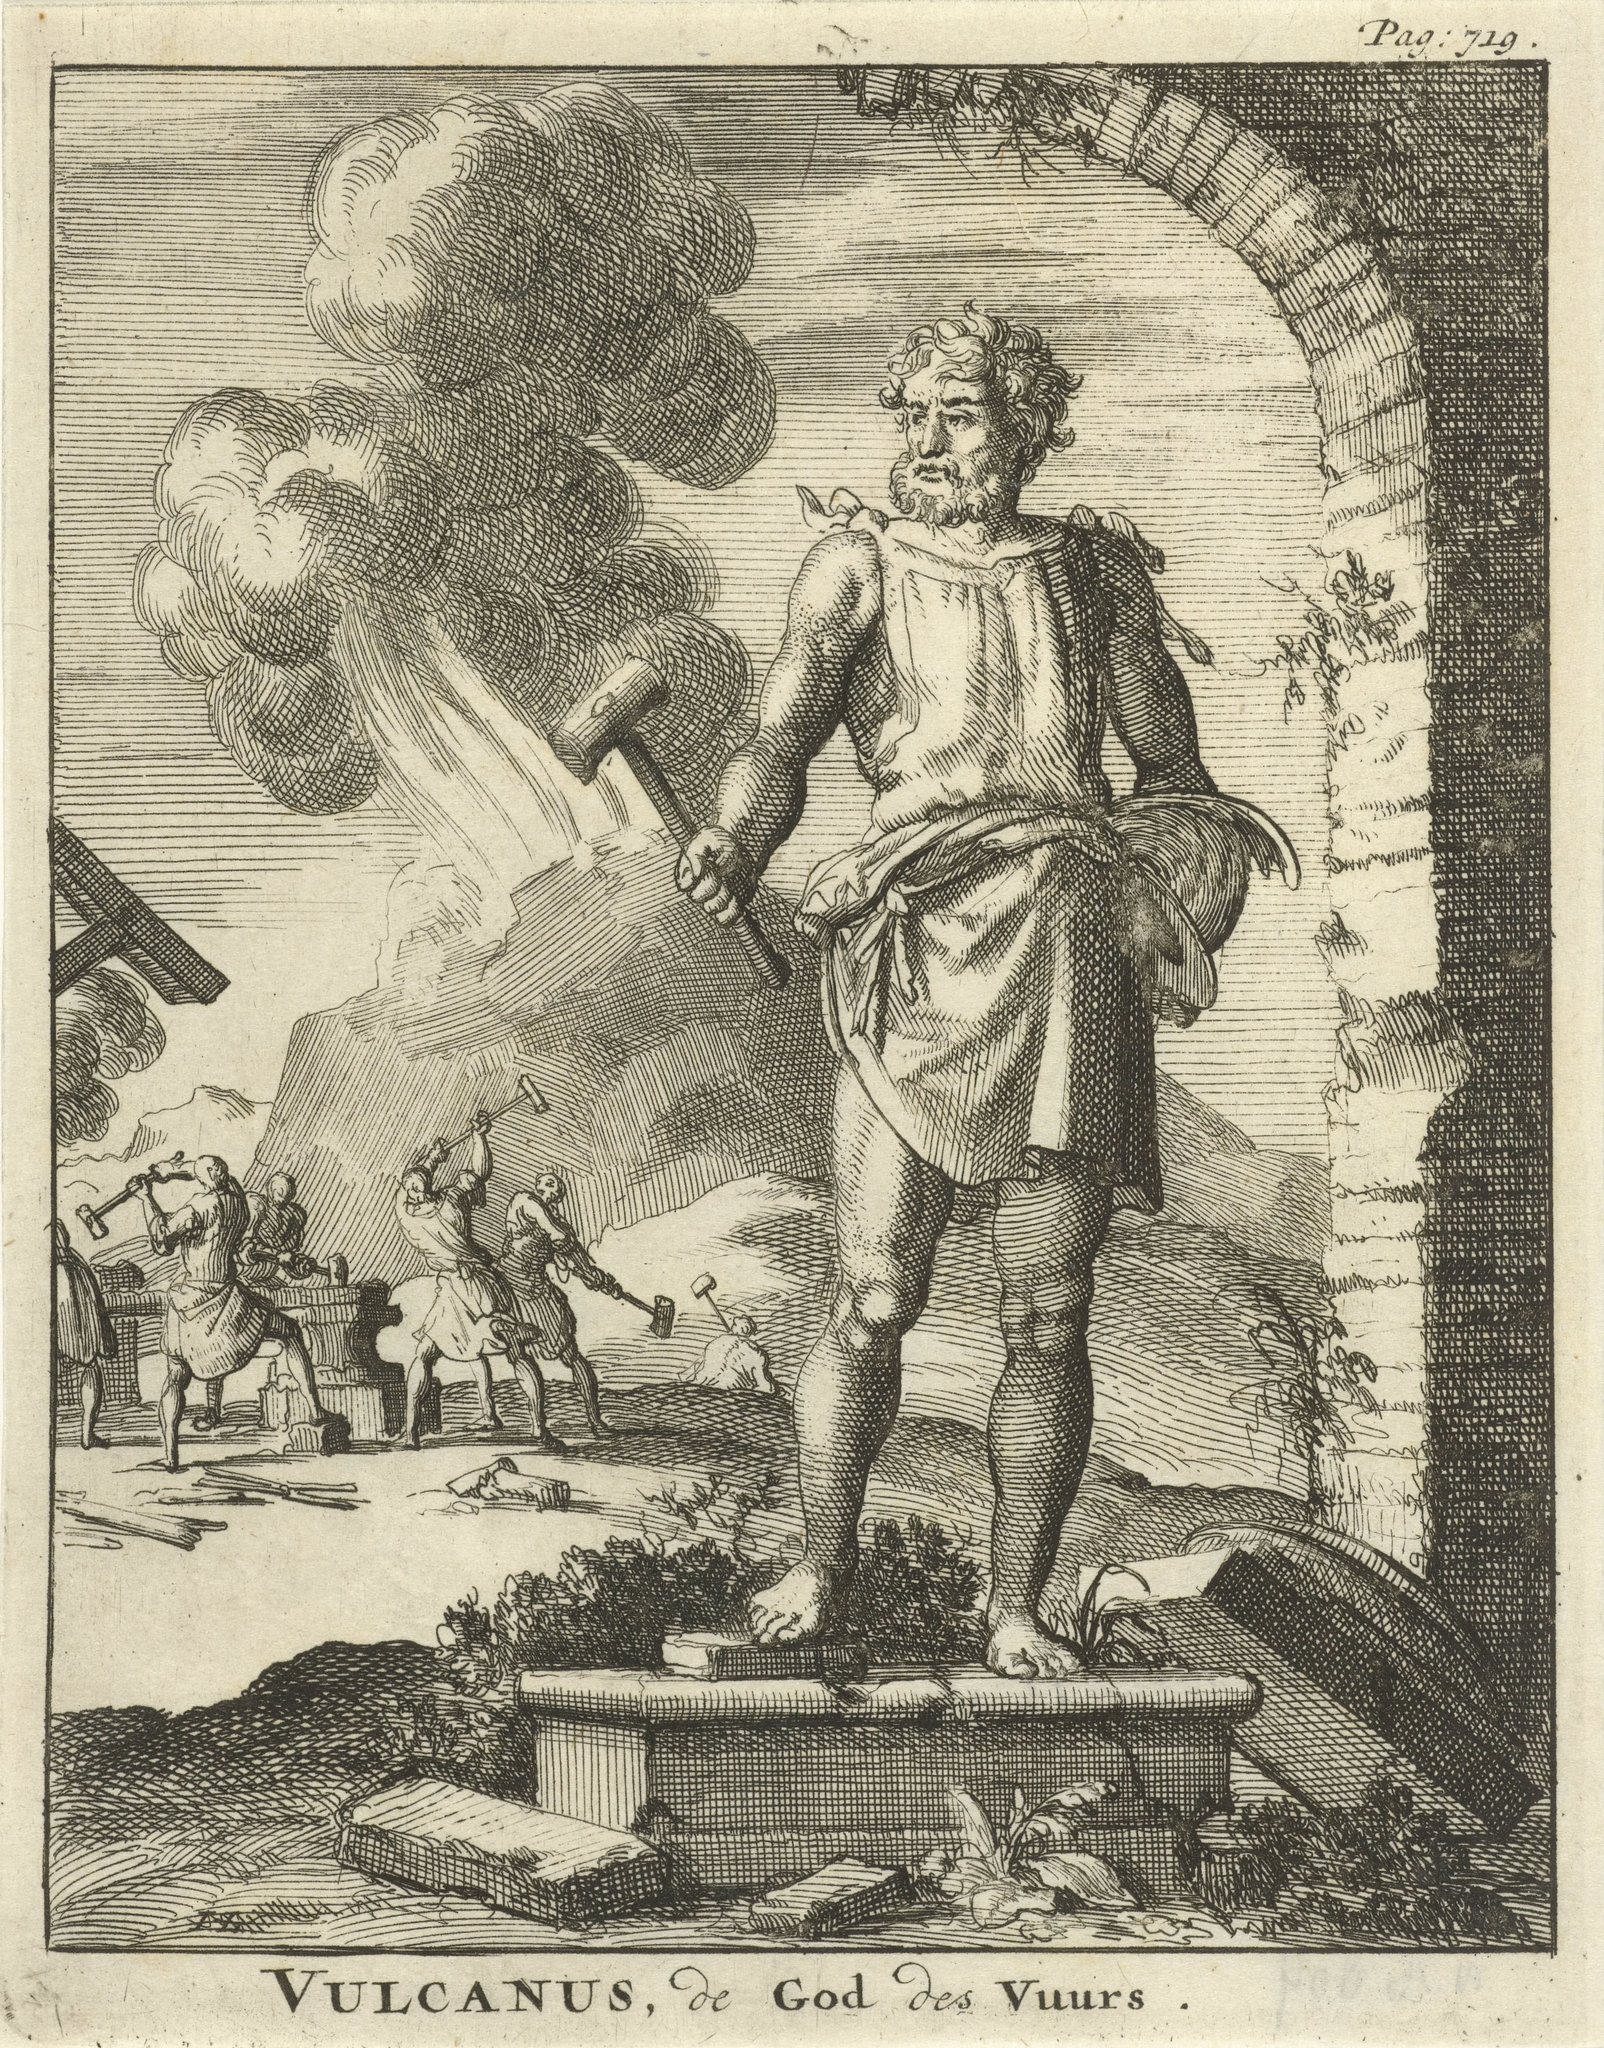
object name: book illustration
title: Standbeeld van Vulcanus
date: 1686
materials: paper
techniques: etching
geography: amsterdam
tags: (story of) vulcan (hephaestus), statues, paintings, etc. ~ objects of worship in roman religion, smith, blacksmith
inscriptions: collector's mark: Lugt 2228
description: Illustratie uit: Aysma, Joannes. Het ryck der goden, onder den eenige waare God, 2 delen. Amsterdam: Timotheus ten Hoorn, 1686, dl. II, p. 729.